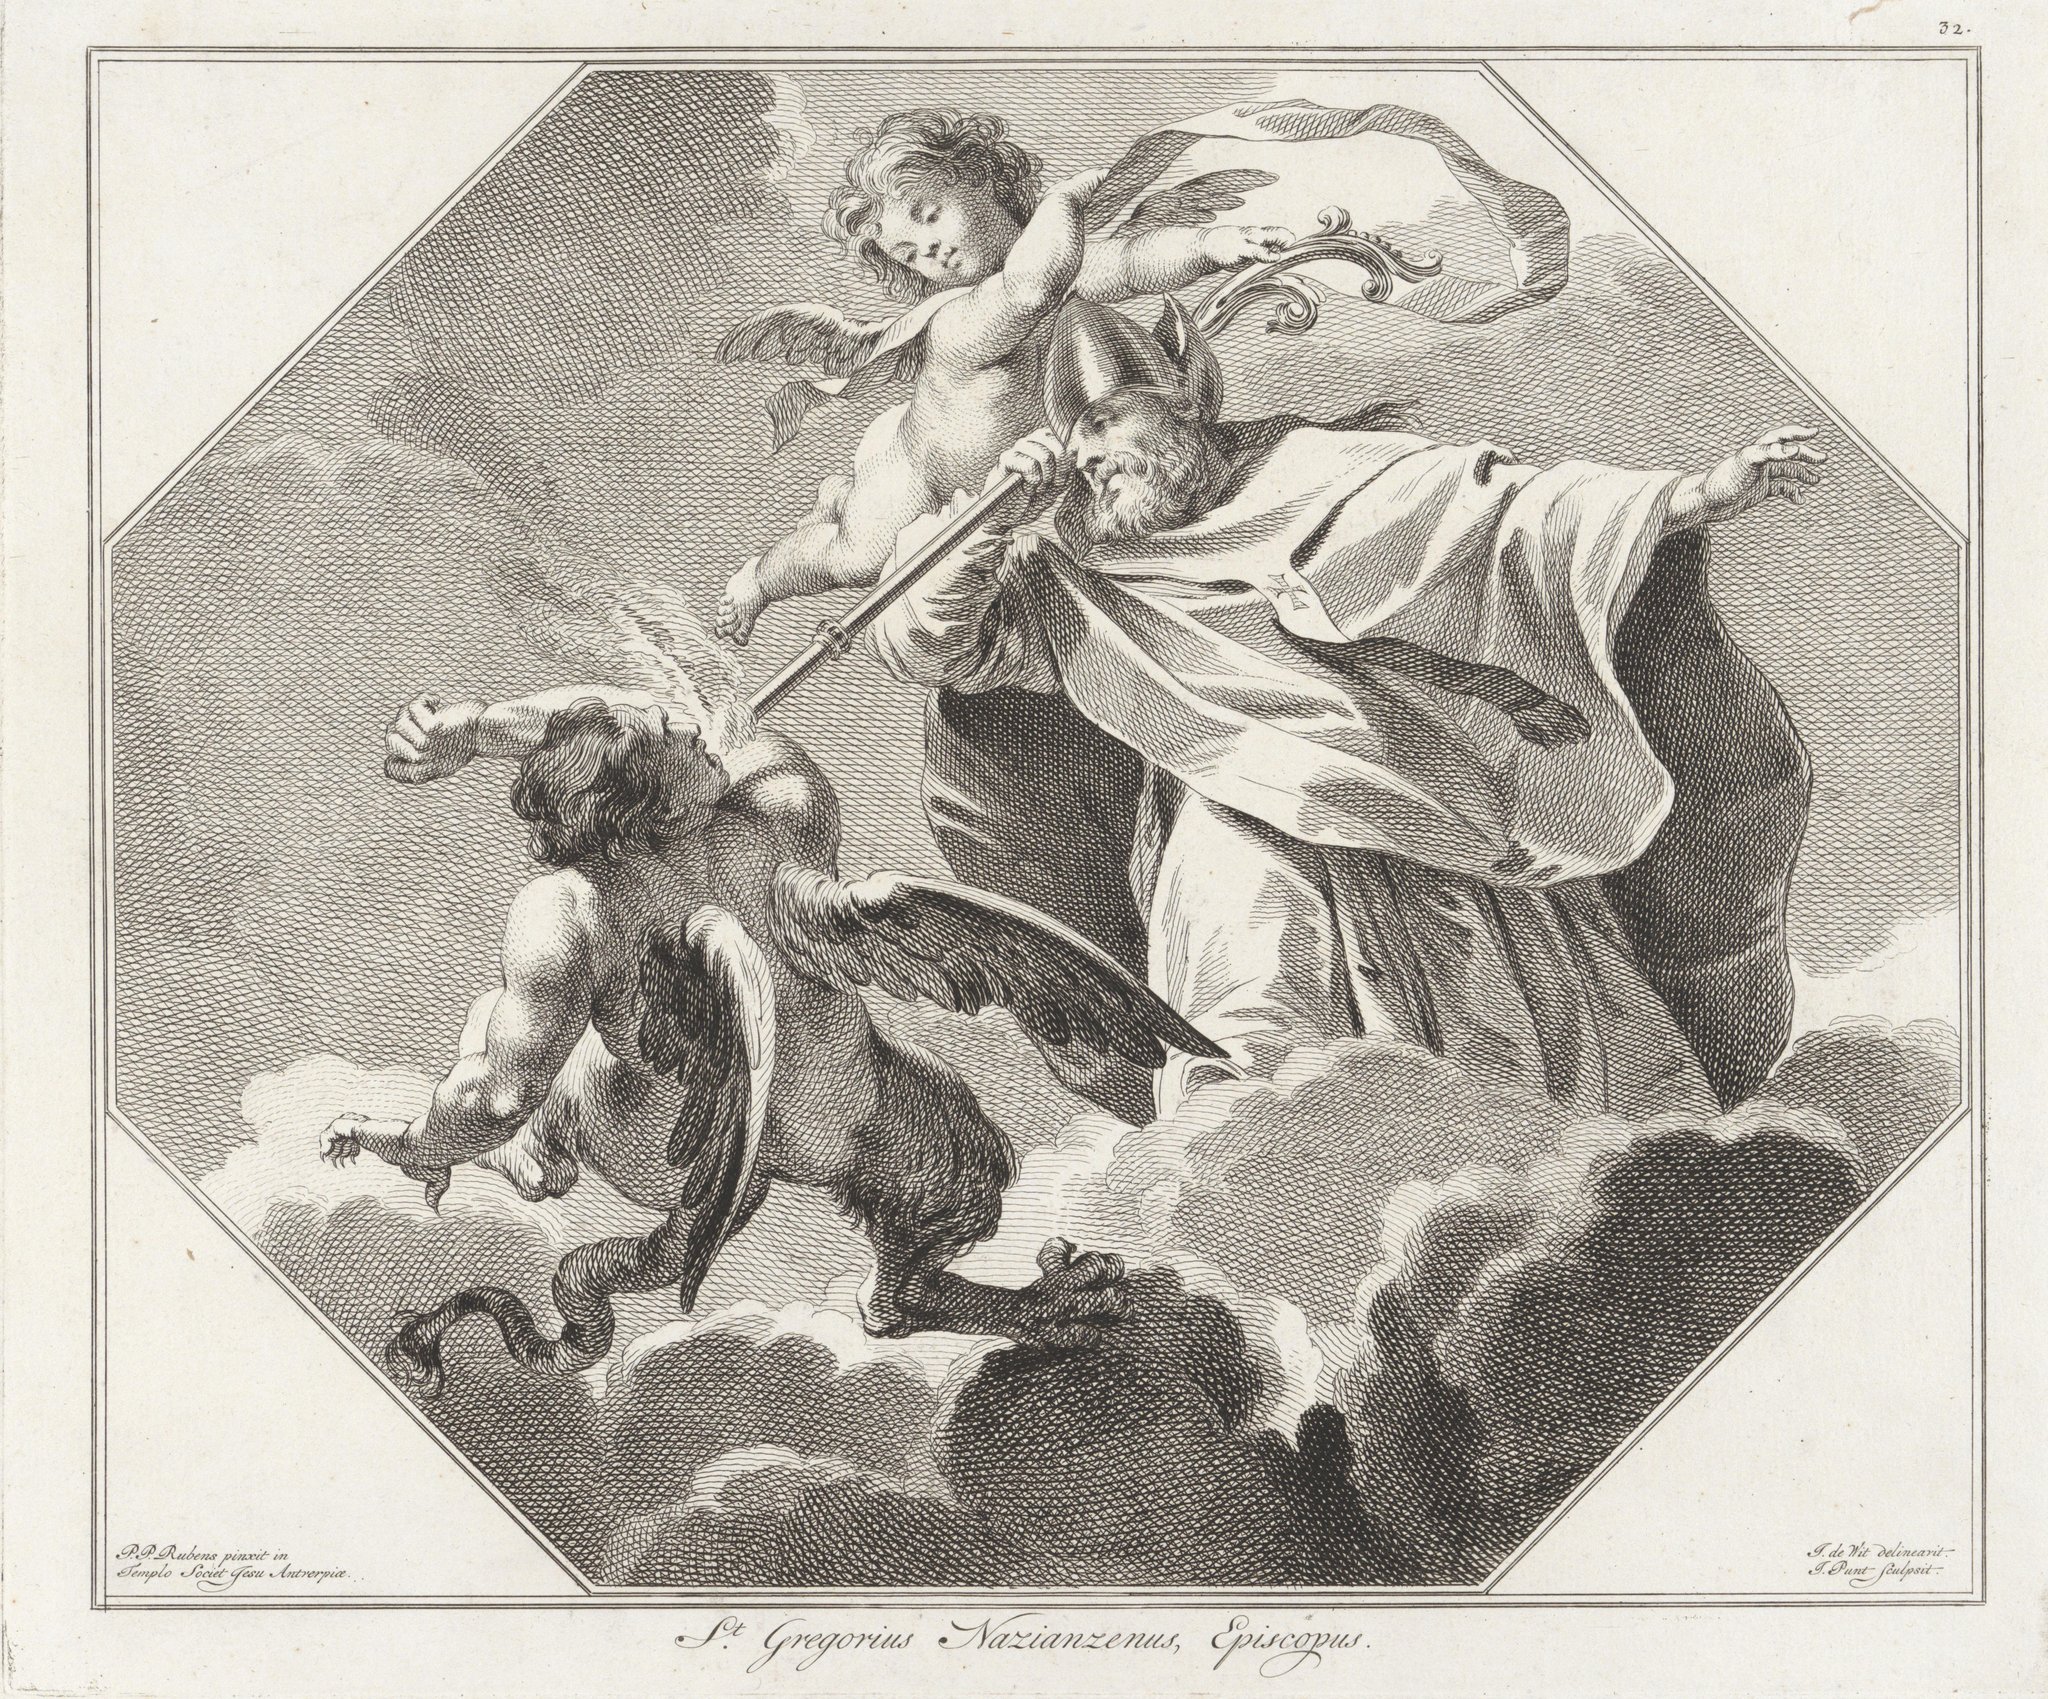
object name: print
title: Les plat-fonds ou les tableaux des galeries / De plafonds of gallerystukken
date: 1751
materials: paper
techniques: engraving, etching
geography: amsterdam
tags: st. gregory of nazianzus fighting against heresy, trampling lucifer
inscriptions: collector's mark: Lugt 240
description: De heilige Gregorius van Nazianze de Jongere verjaagt met zijn bisschopsstaf een monster (de ketterij). Boven hem vliegt een engel. Onder de octagonale voorstelling een opschrift in het Latijn.